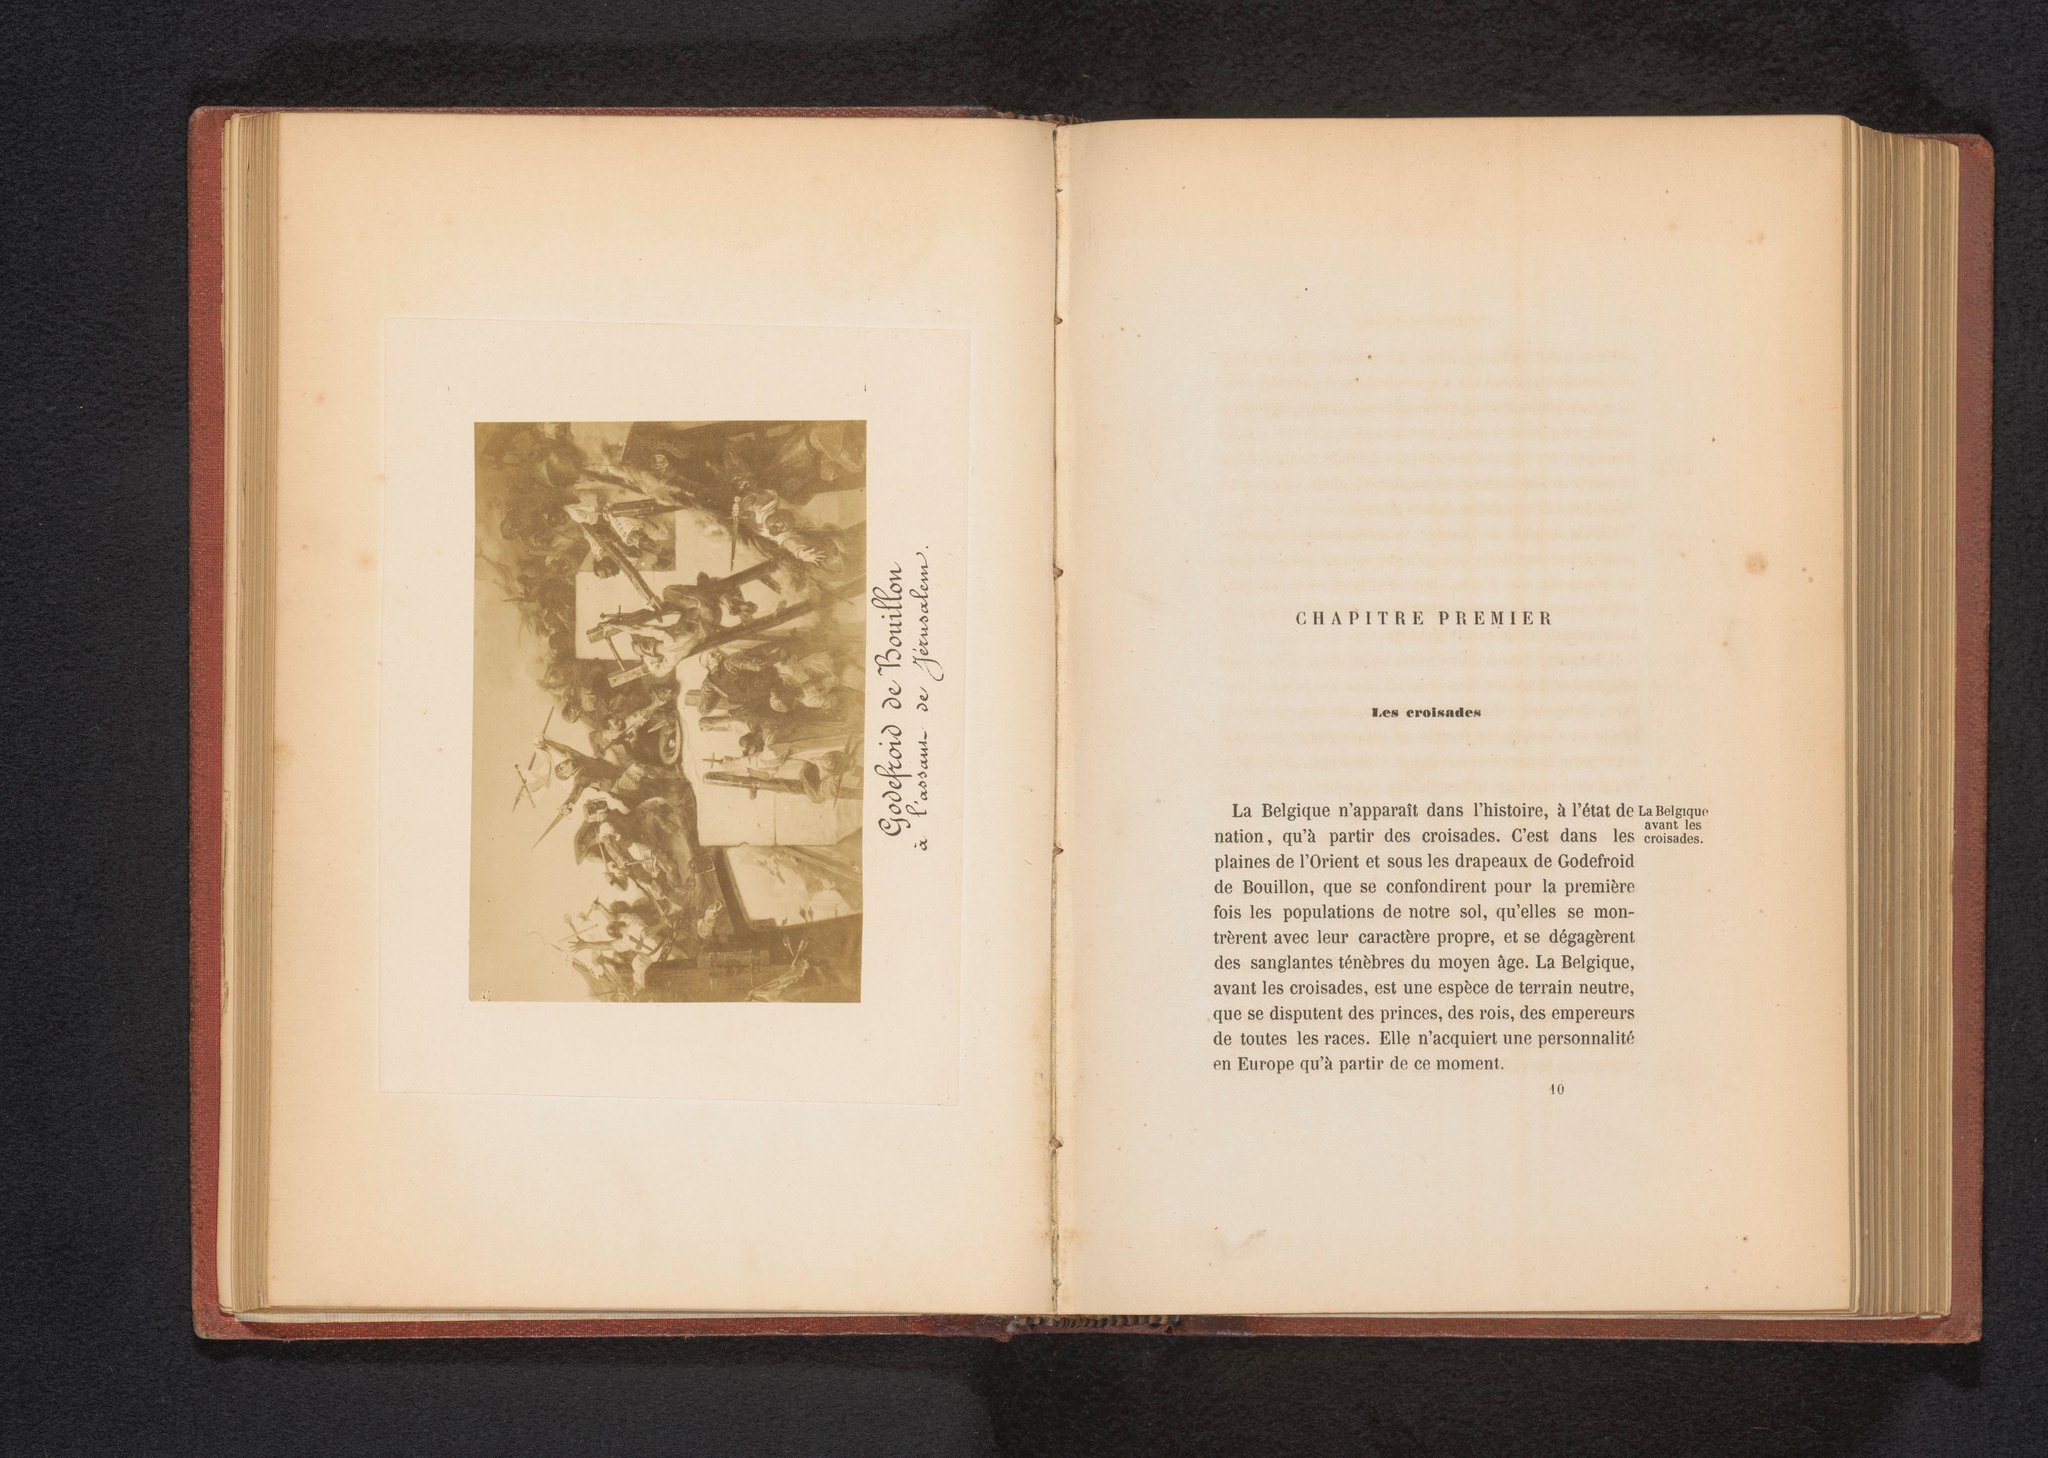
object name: reproduction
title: Godfried de Bouillon à l'assaut de Jérusalem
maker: joseph maes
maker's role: fotograaf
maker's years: 1838-1908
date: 1855-1860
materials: photographic support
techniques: albumen print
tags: militant proselytizing: religious war, crusade, etc.